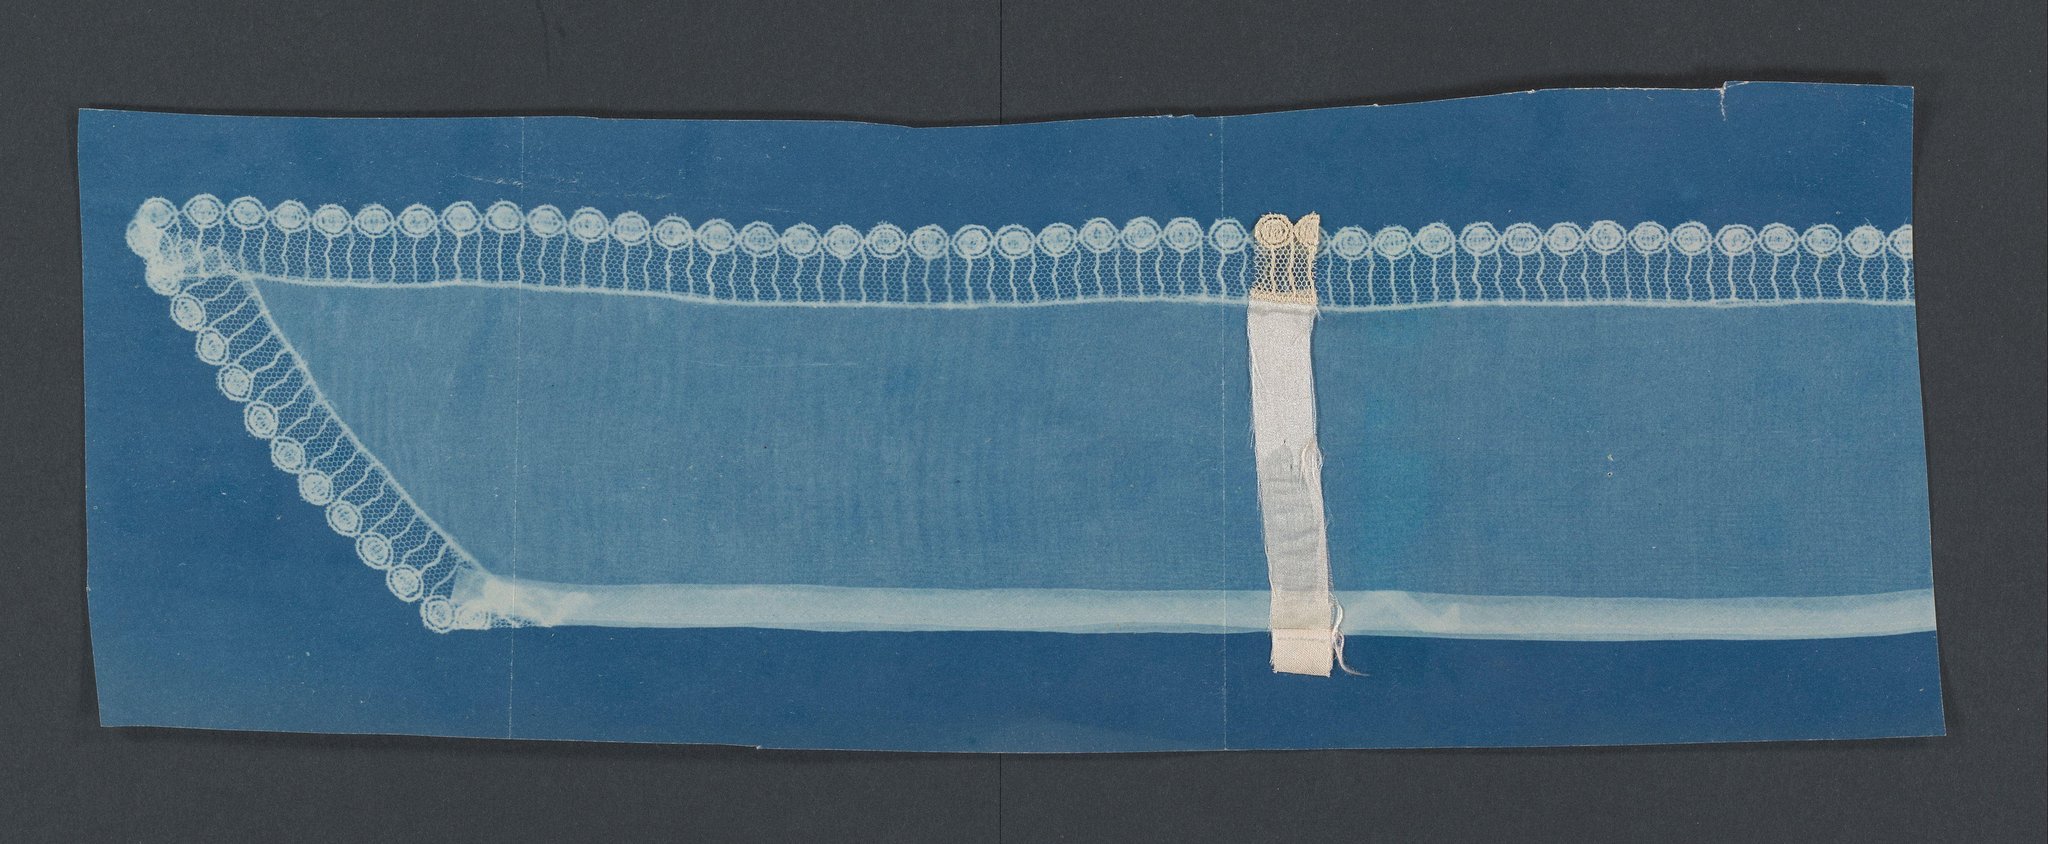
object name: photogram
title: Kant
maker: Anonymous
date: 1900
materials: paper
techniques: cyanotype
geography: france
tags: lace